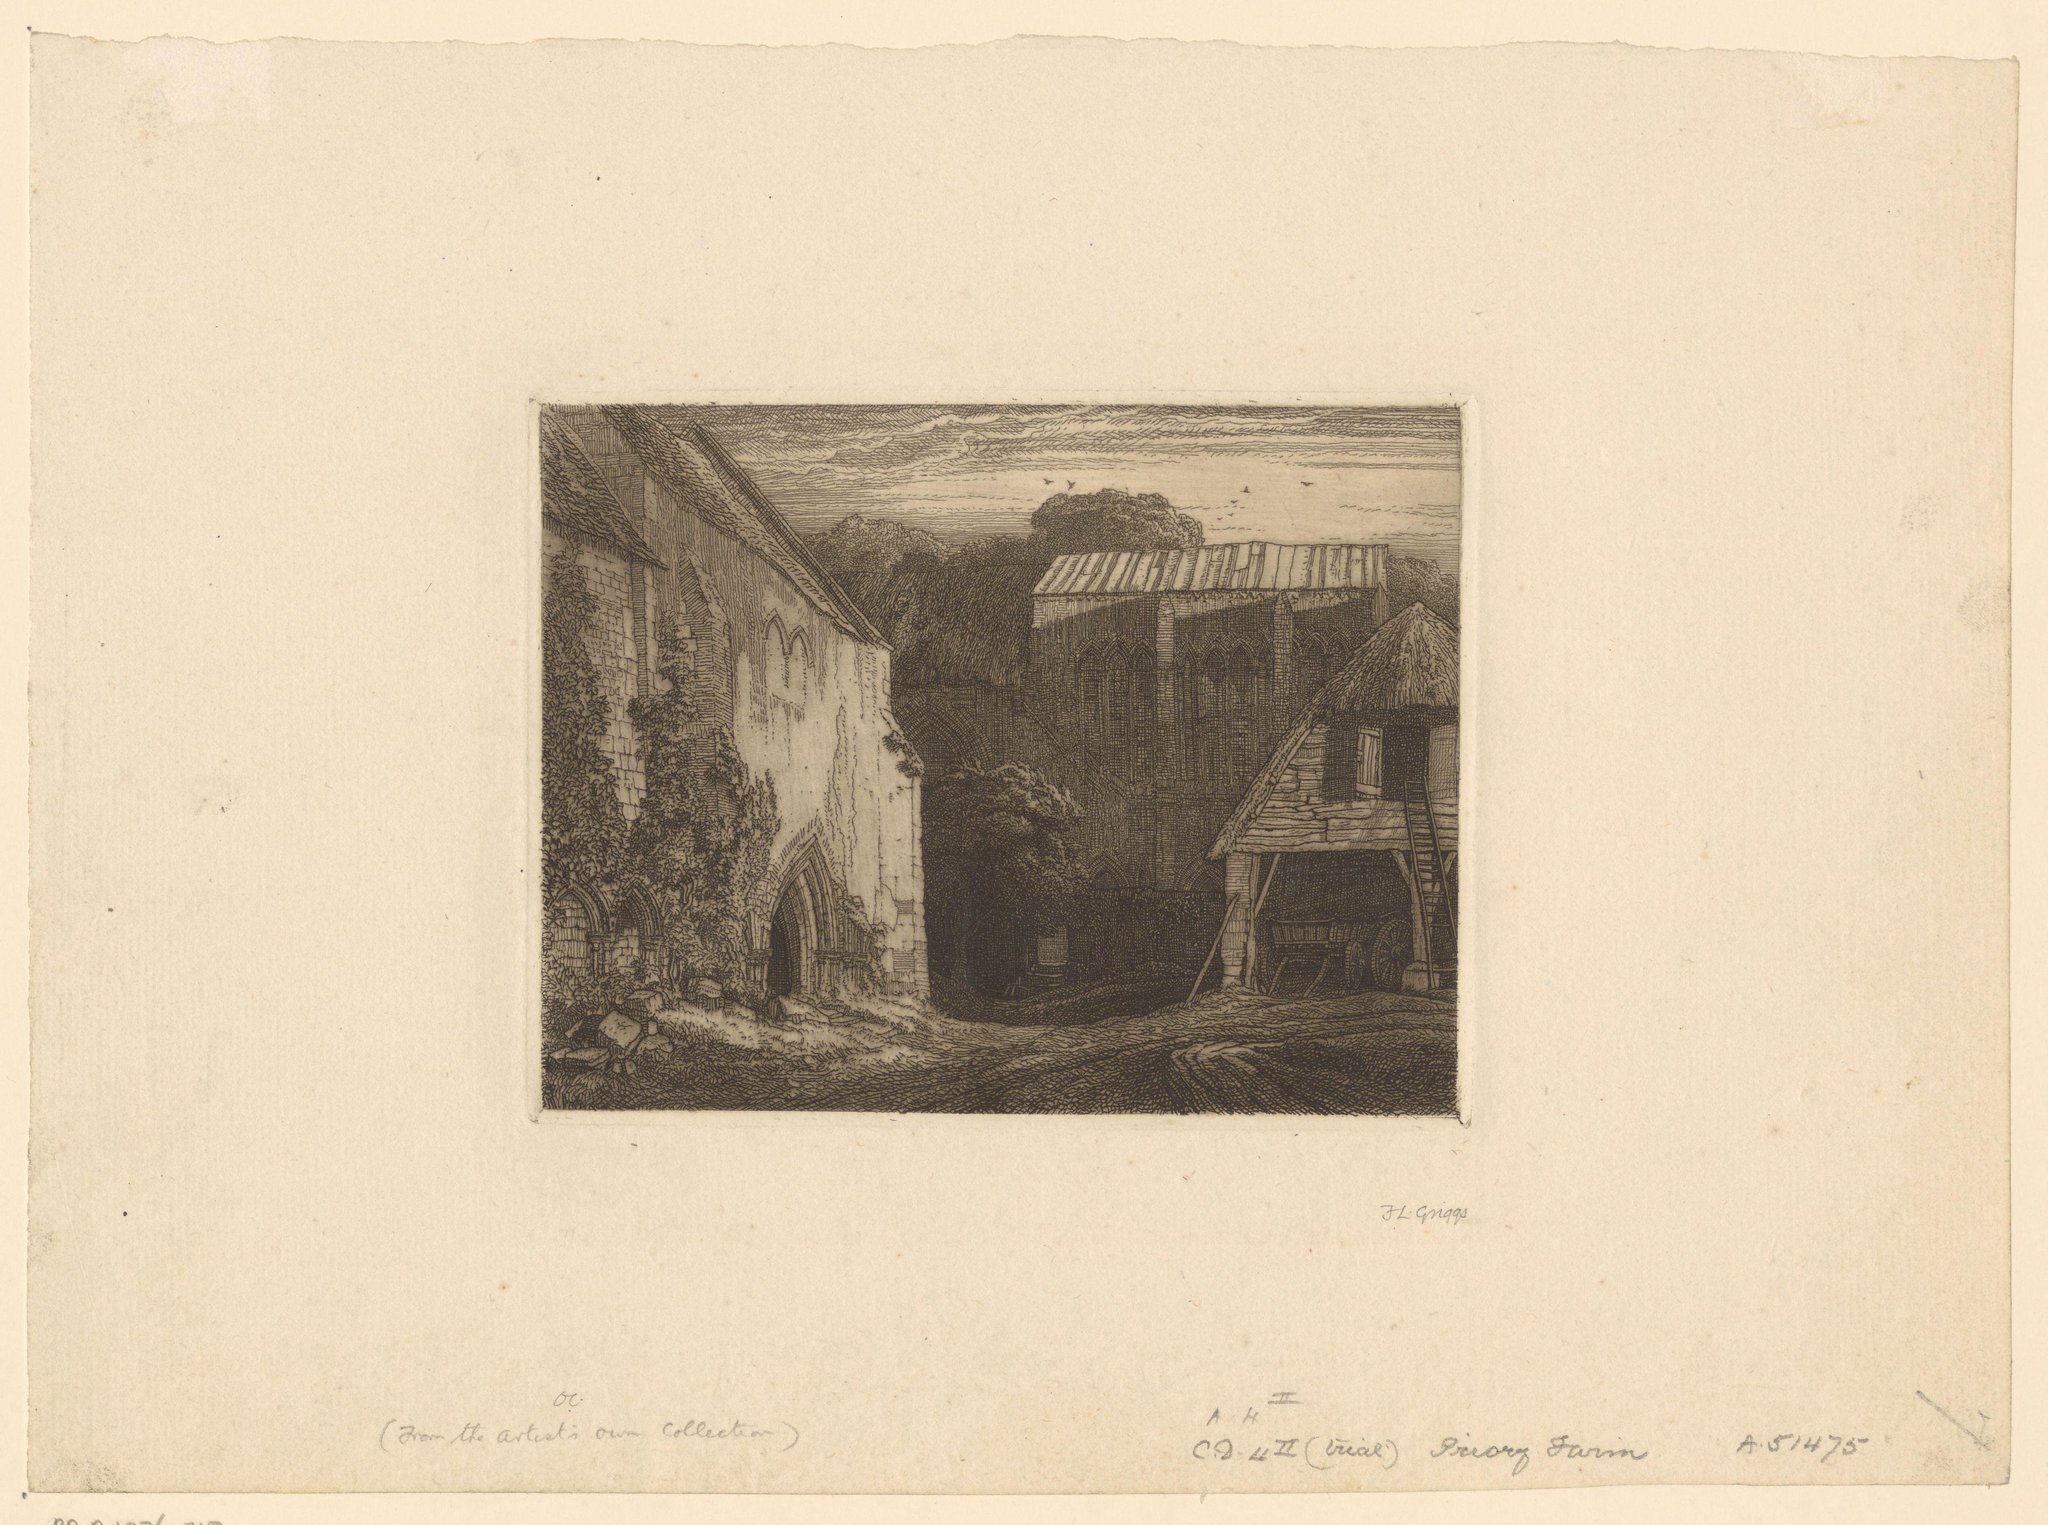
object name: print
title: Boerderij bij een priorij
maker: frederick landseer maur griggs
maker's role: print maker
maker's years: 1876-1938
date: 1913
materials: paper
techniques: etching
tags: church (exterior), farm (building)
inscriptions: signature: ‘F.L. Griggs’, collector's mark: Lugt 2228